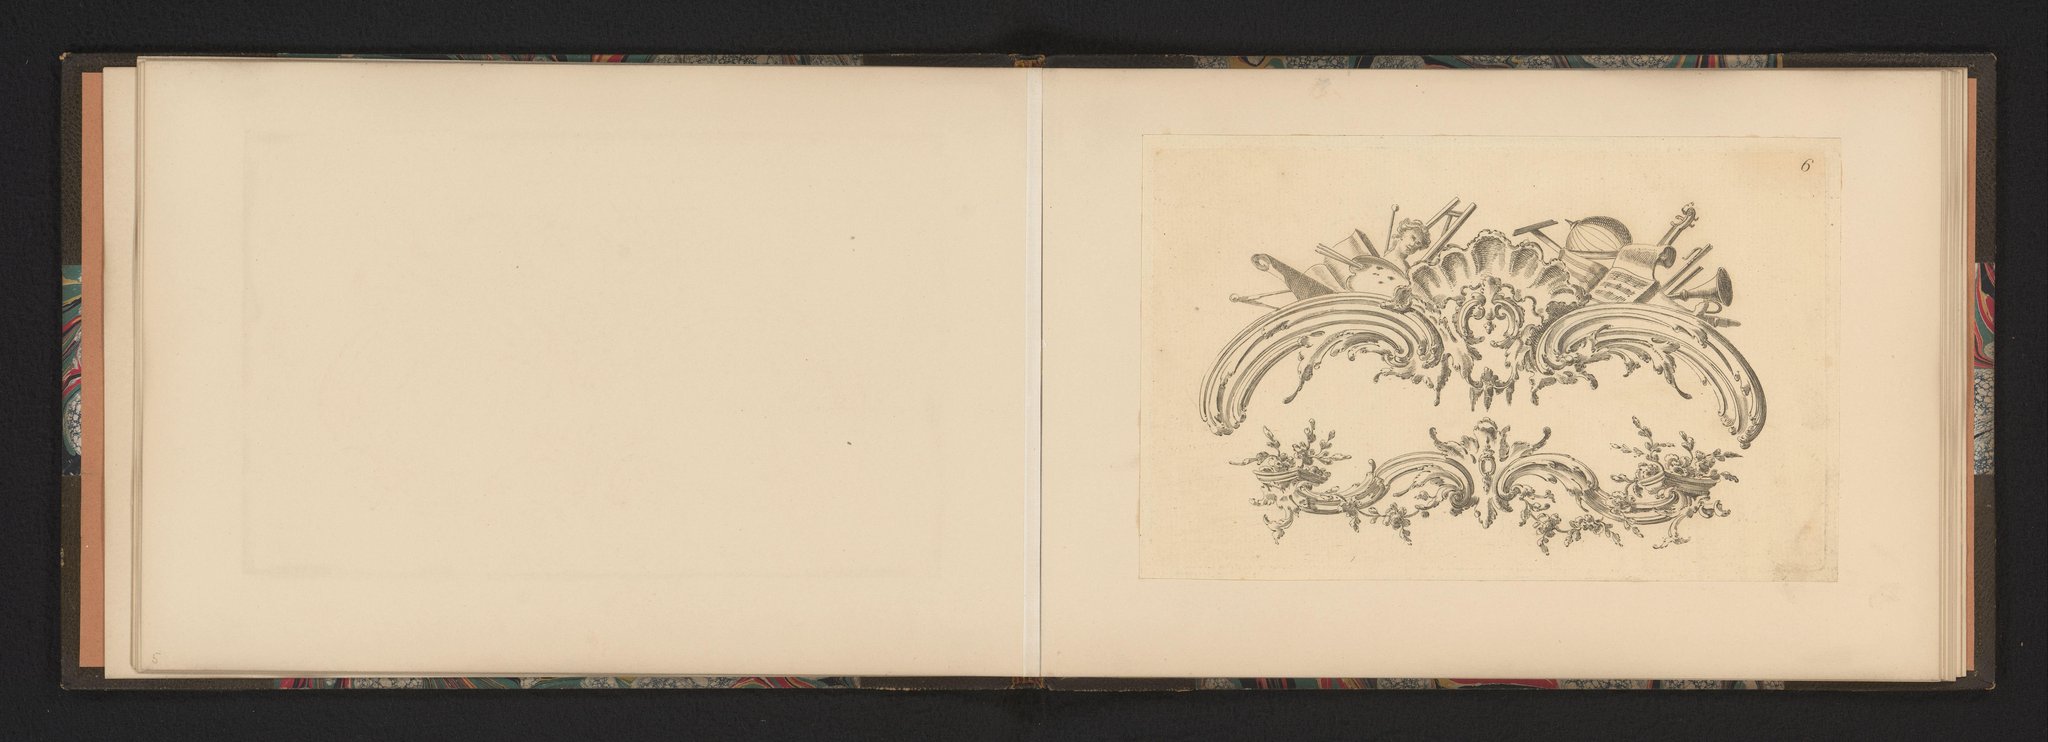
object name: ornament print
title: Ornamentele versiering met schildersbenodigdheden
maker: p. baretti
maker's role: print maker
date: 1766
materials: paper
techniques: engraving, etching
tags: ornaments ~ art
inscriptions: number: ‘6’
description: Ingeplakte prent met ornamentele versiering met schildersbenodigdheden. Prent maakt deel uit van een album.